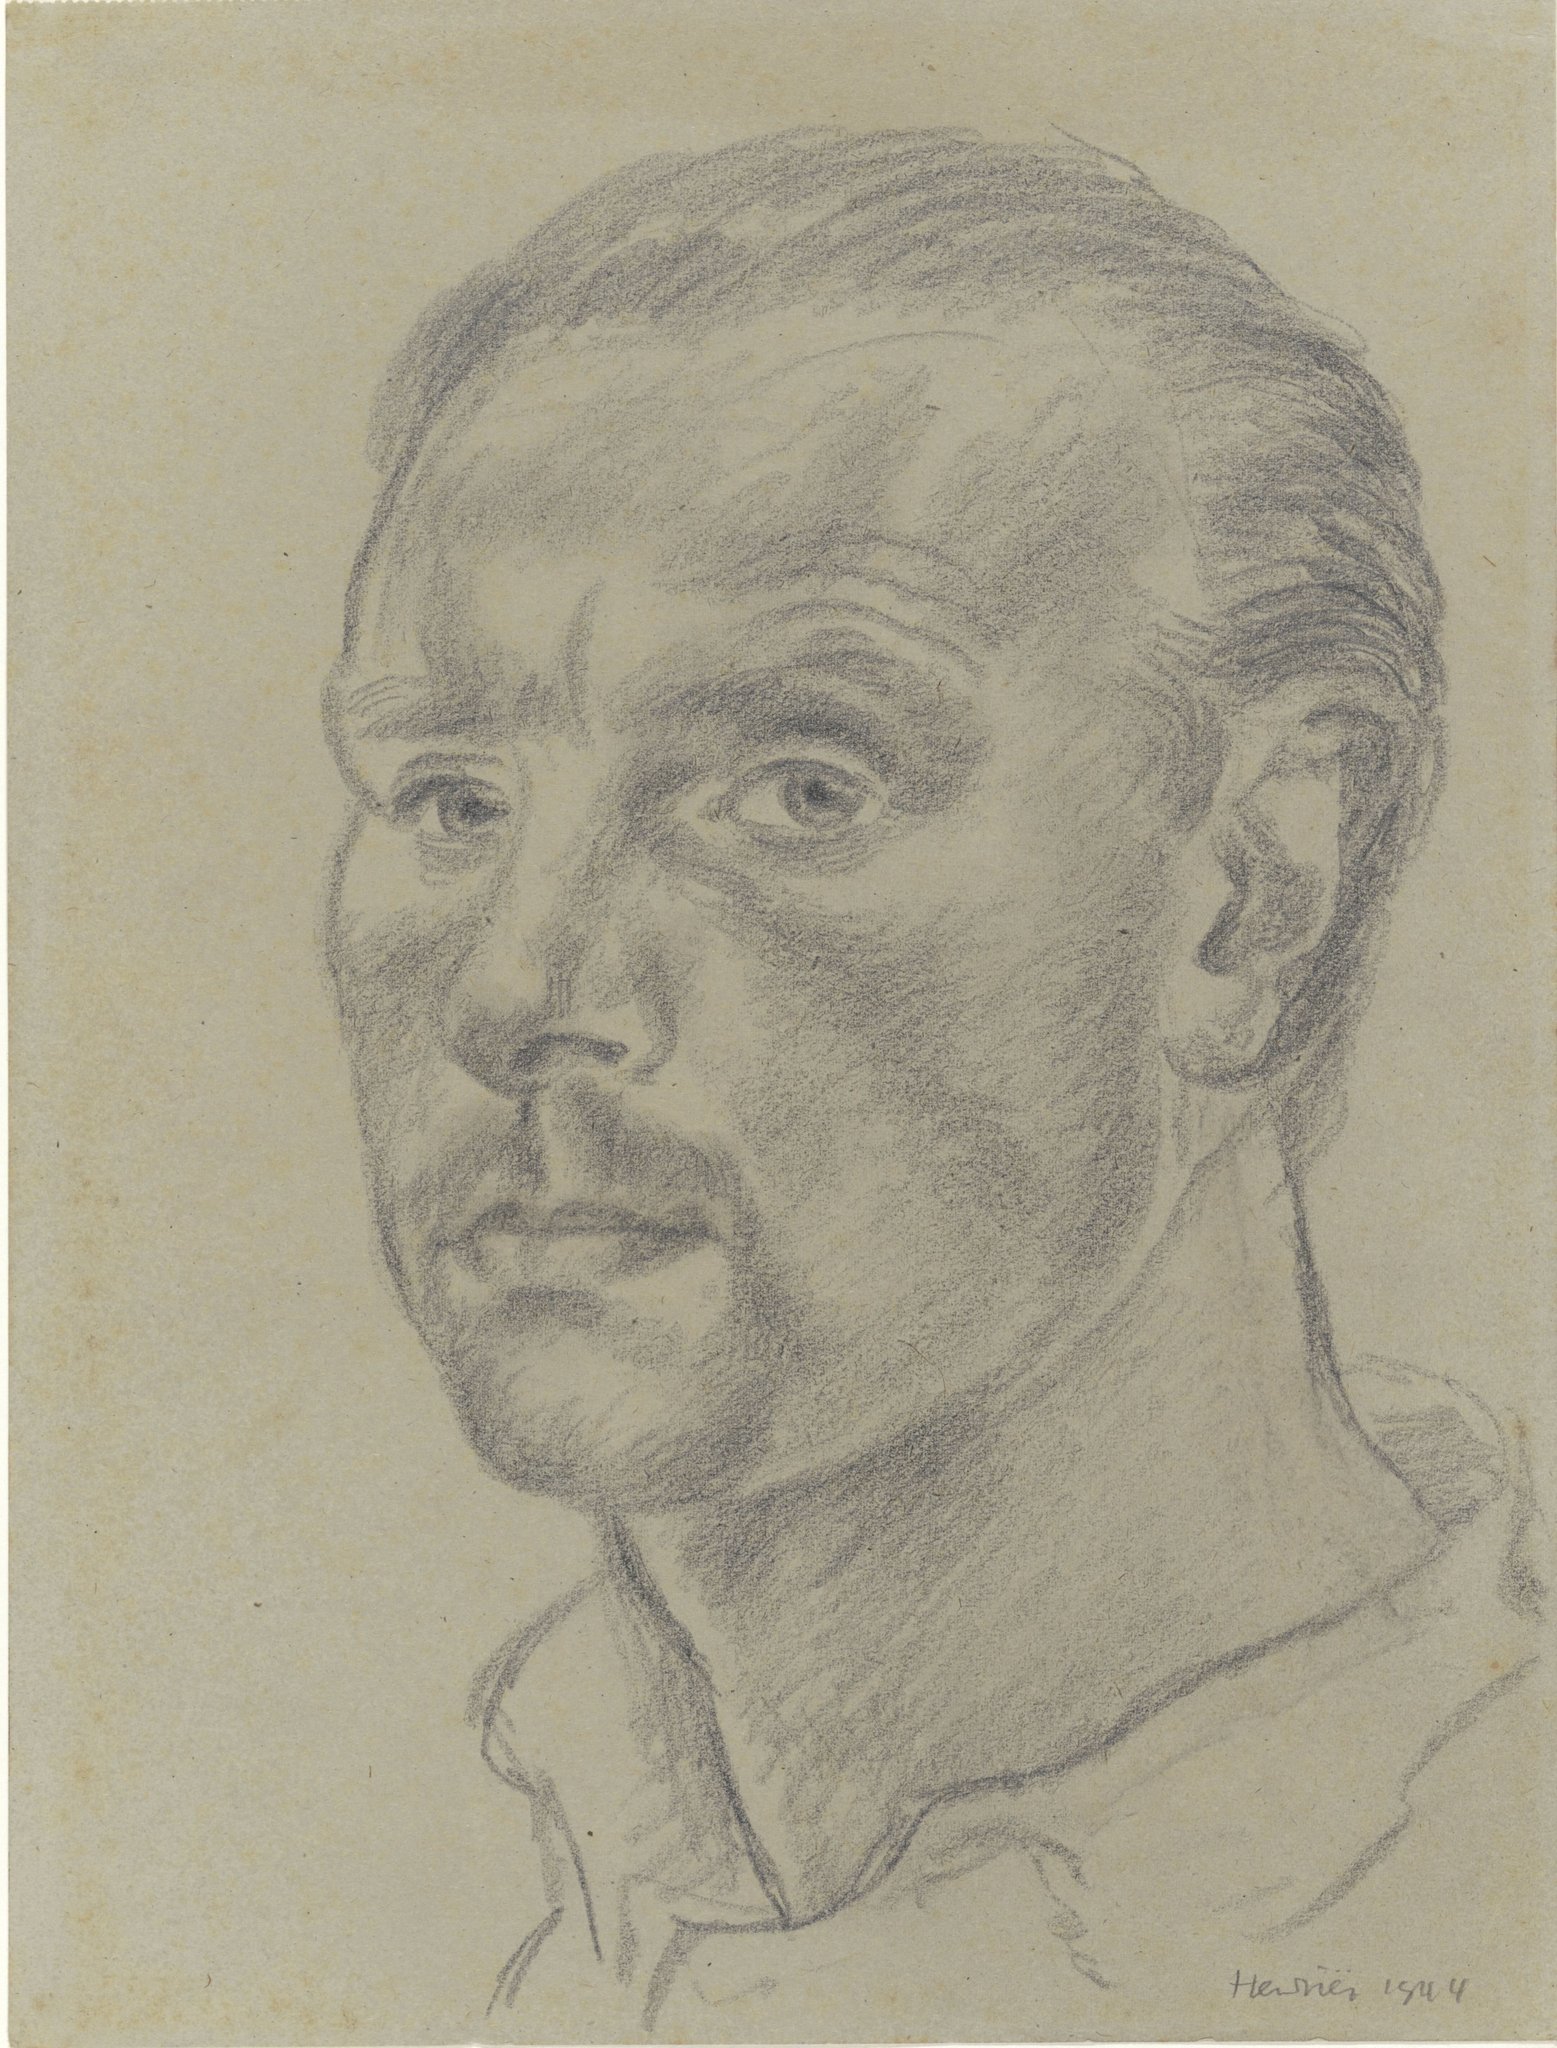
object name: drawing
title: Portret van een onbekende man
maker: henk henriët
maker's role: draughtsman, print maker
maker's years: 1903-1945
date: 1944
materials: paper, pencil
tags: anonymous historical person portrayed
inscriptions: collector's mark: Lugt 2228